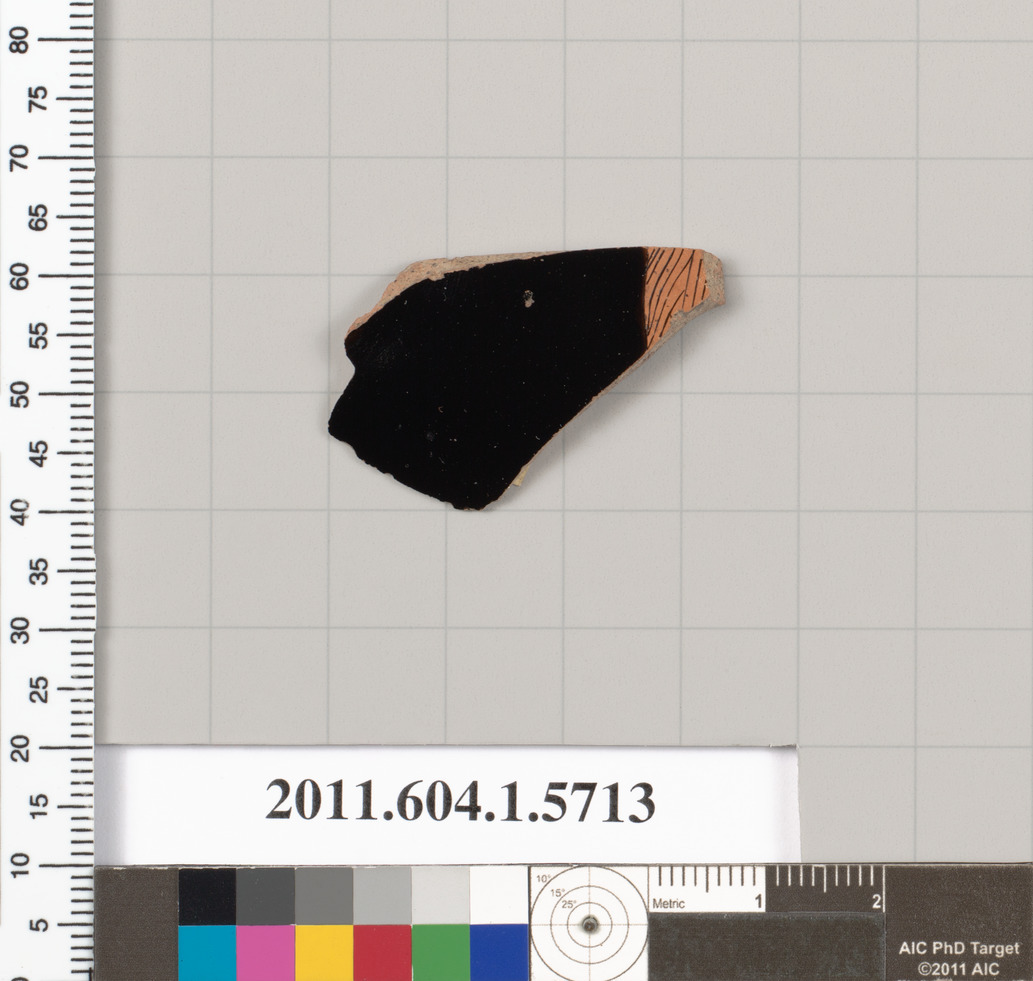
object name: kylix fragment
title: Terracotta fragment of a kylix (drinking cup)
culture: greek, attic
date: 490-480 BCE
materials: terracotta